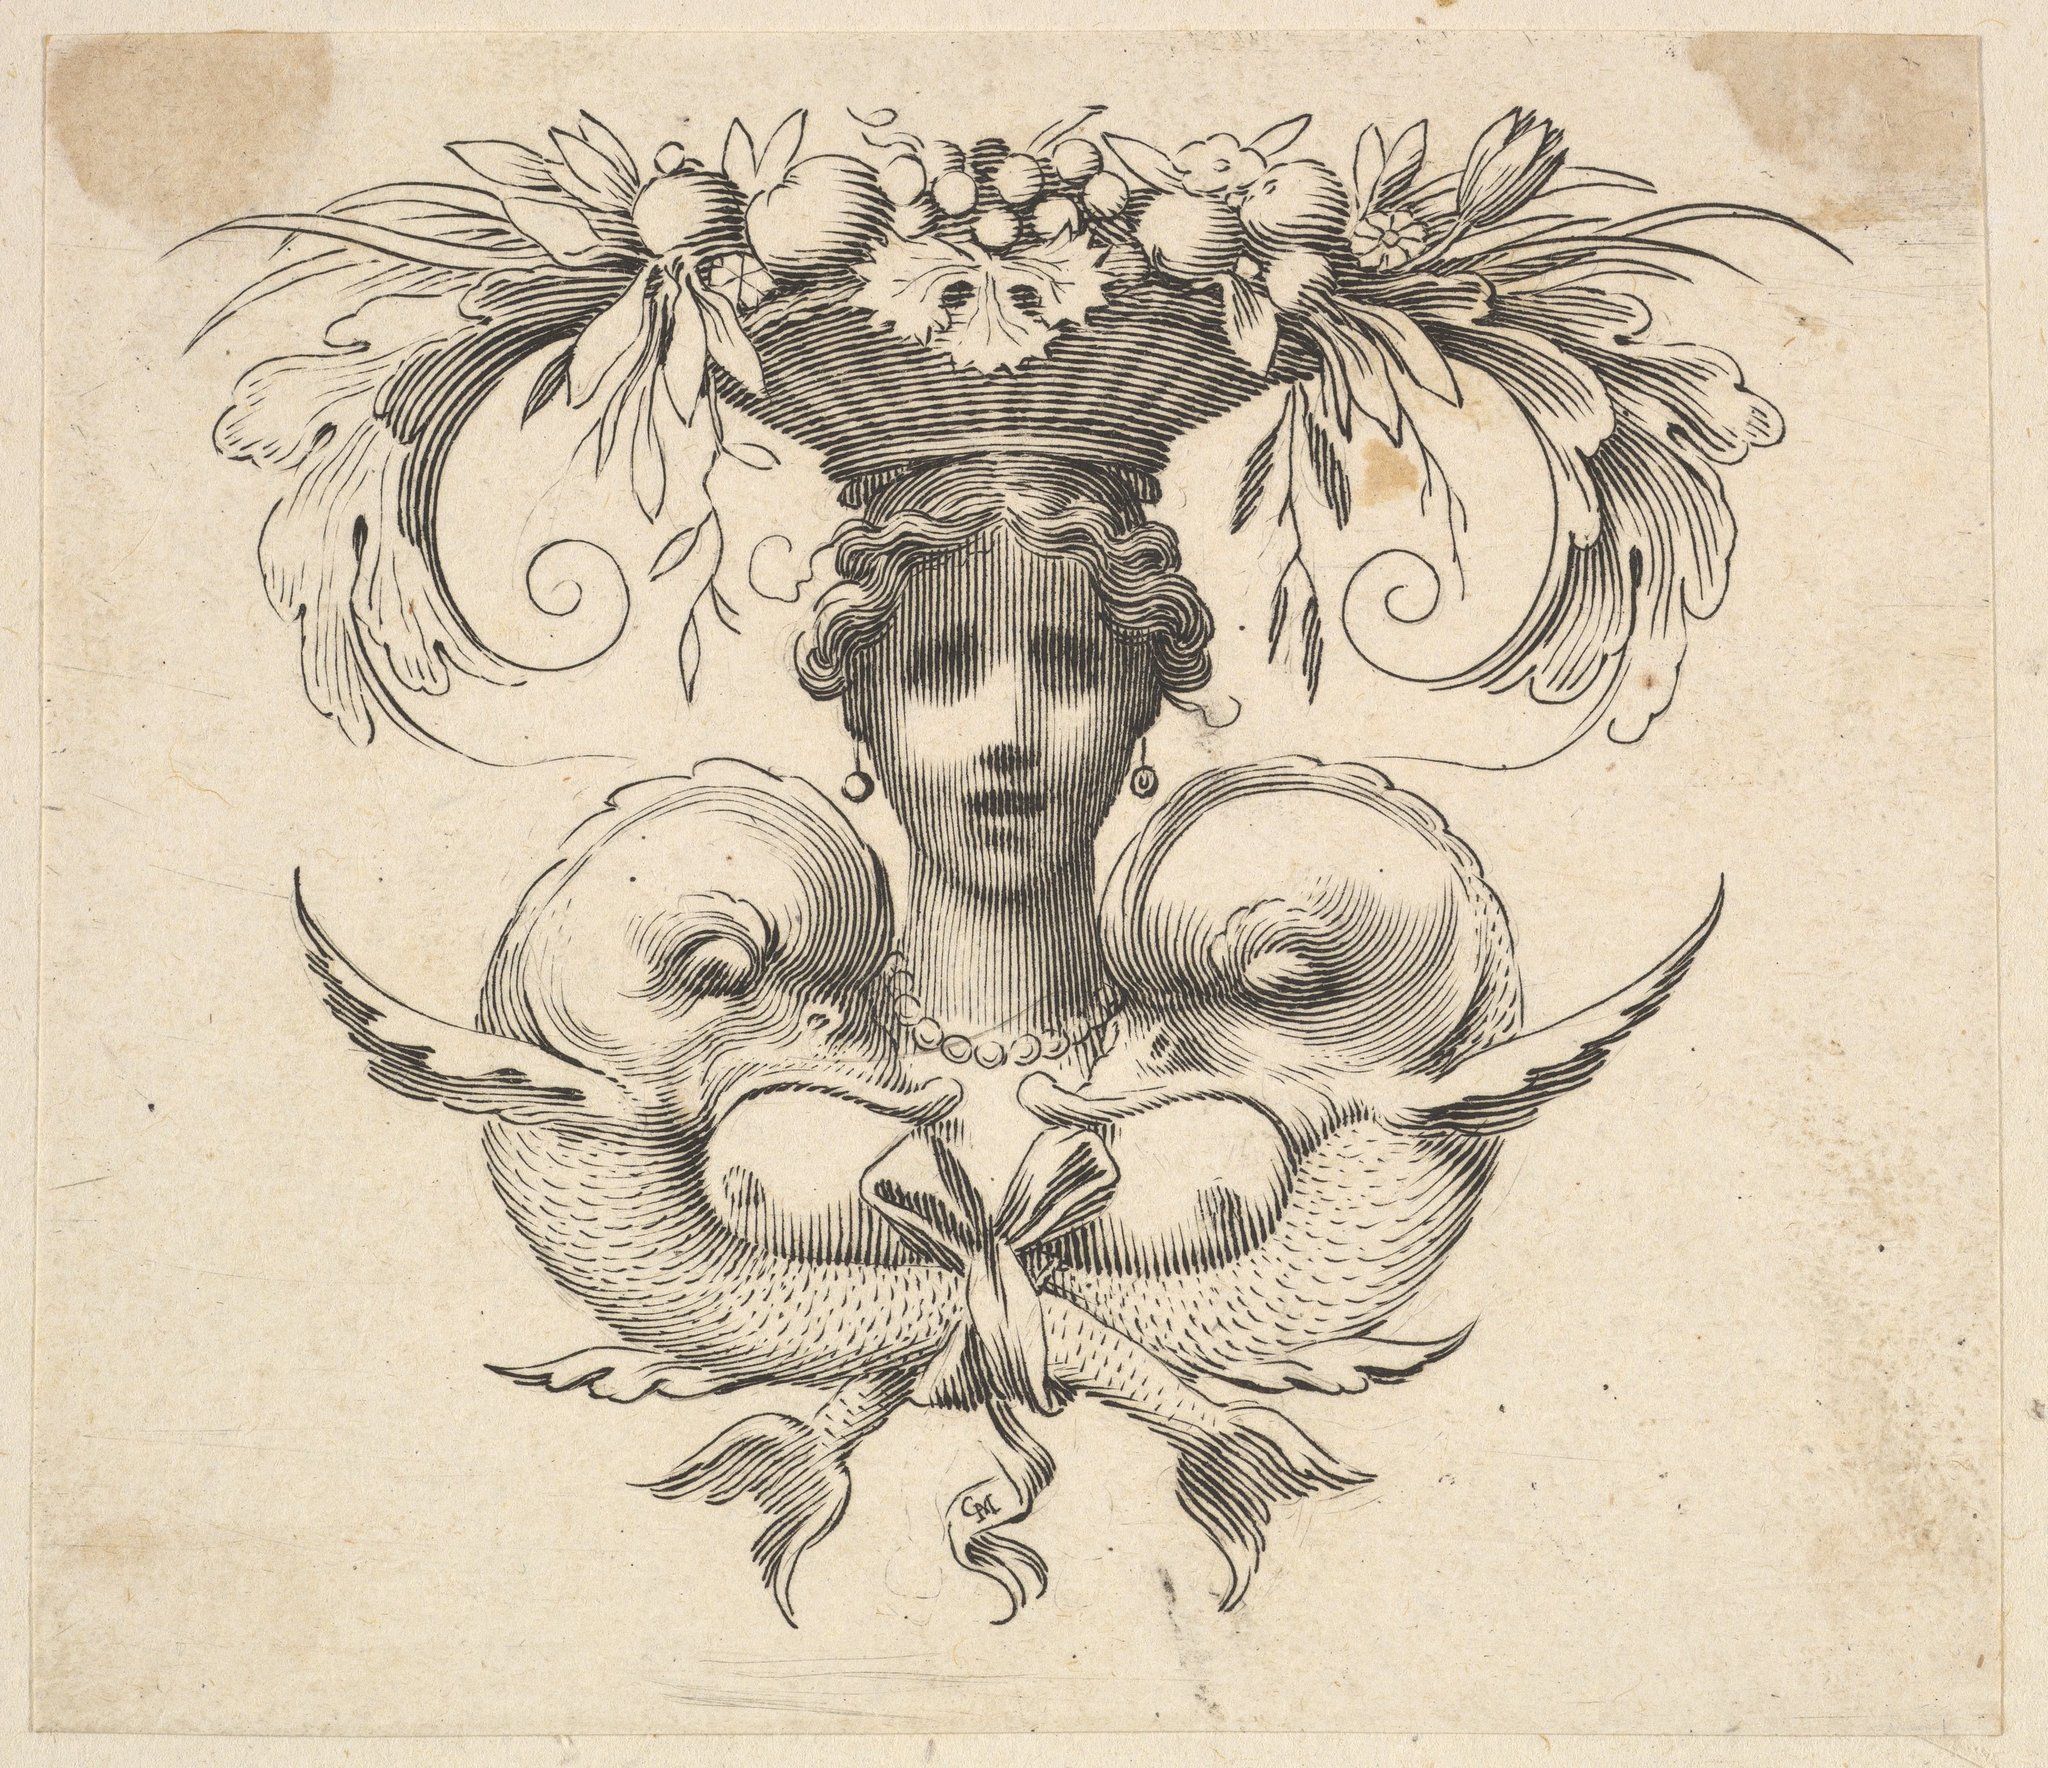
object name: print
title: Tail-piece: Woman's Head (Cul-de-lampe: Buste de femme)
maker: claude mellan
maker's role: artist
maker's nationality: french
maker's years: 1598-1688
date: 1600-1688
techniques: engraving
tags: food,heads,women,dolphins,leaves